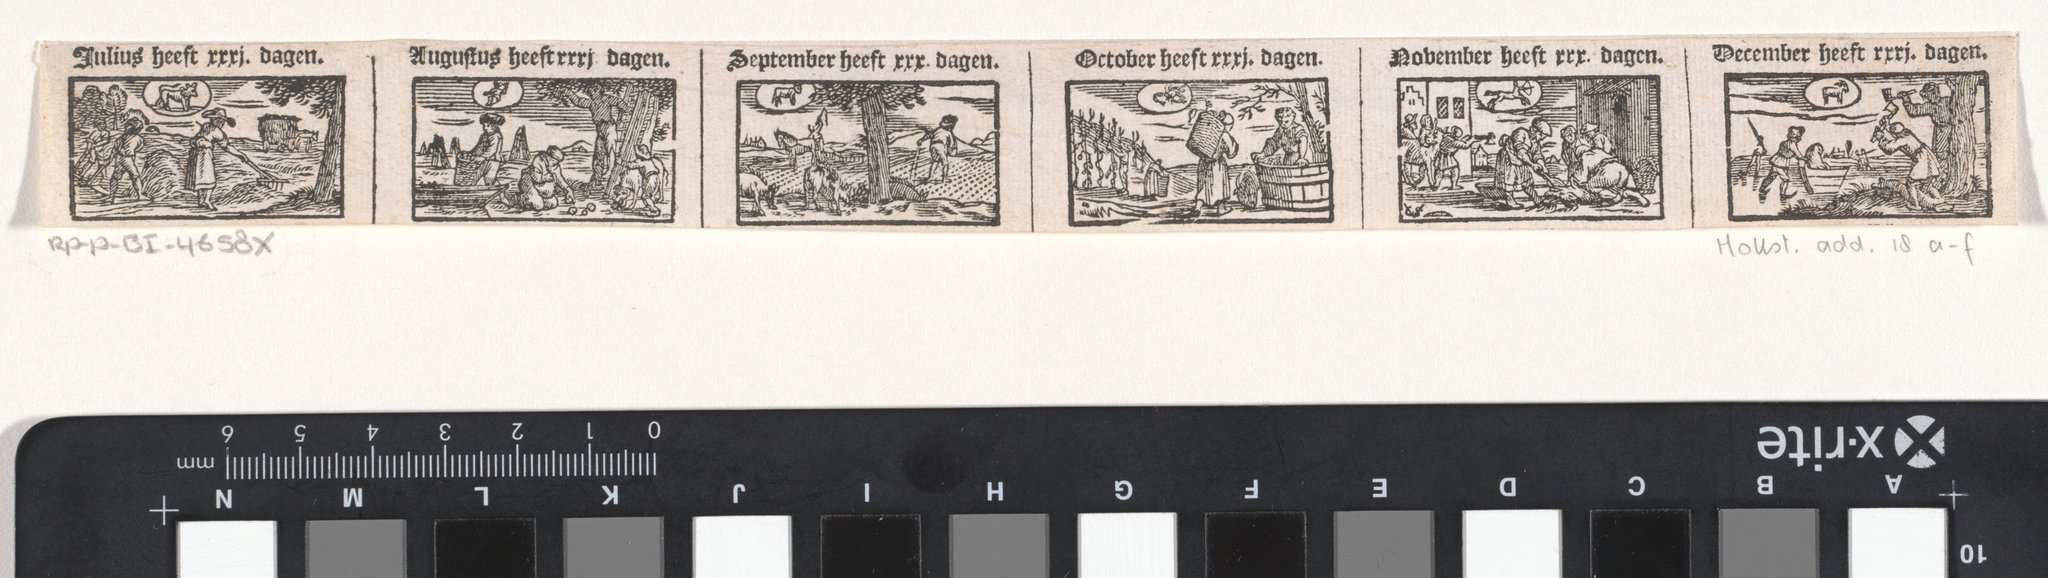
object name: print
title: Zes laatste maanden van het jaar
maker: christoffel van sichem (iv)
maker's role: print maker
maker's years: 1642-1698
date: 1652-1698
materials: paper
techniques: letterpress printing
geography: netherlands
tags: september and its 'labours' (+ with libra (september)), october and its 'labours' (+ with scorpio (october)), november and its 'labours' (+ with sagittarius (november)), december and its 'labours' (+ with capricorn (december)), july and its 'labours' (+ with leo (july)), august and its 'labours' (+ with virgo (august))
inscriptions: collector's mark: Lugt 240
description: Blad met zes voorstellingen van juli, augustus, september, oktober, november en december. Boven elke afbeelding een regel Nederlandse tekst.